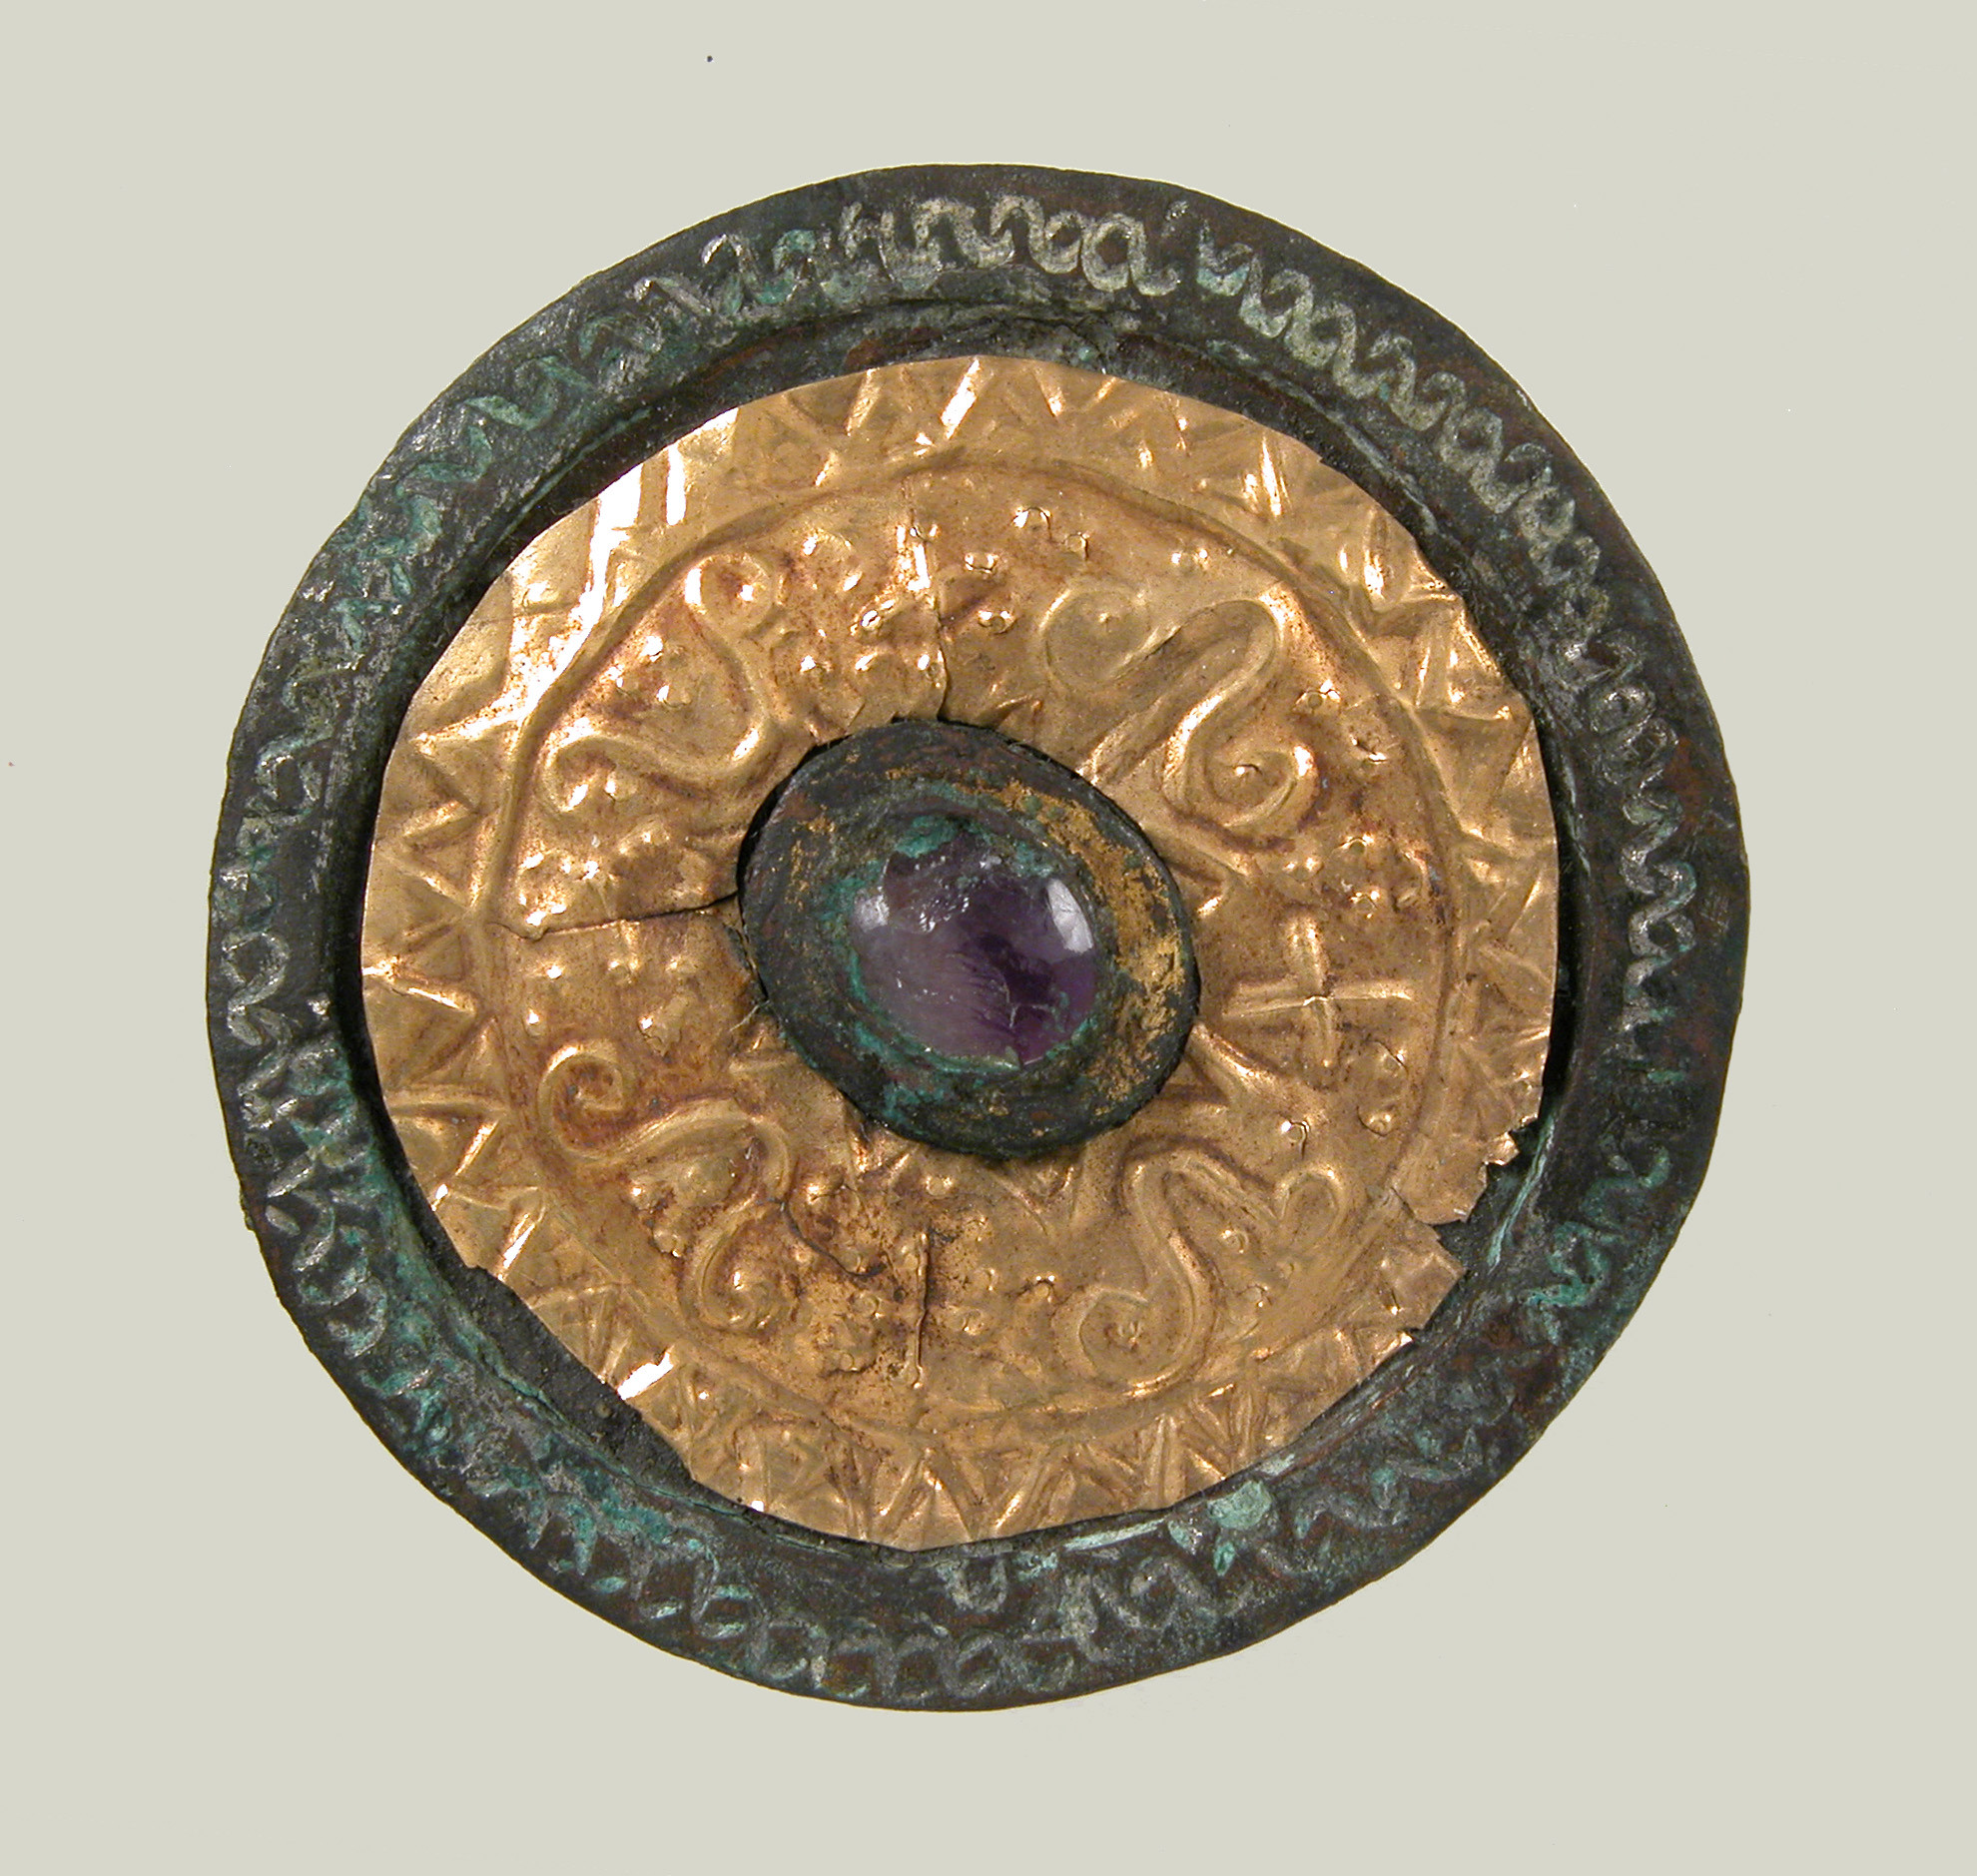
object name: brooch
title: Disk Brooch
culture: frankish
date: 550-650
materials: gemstone, copper alloy, gilt, gold foil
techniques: silvered